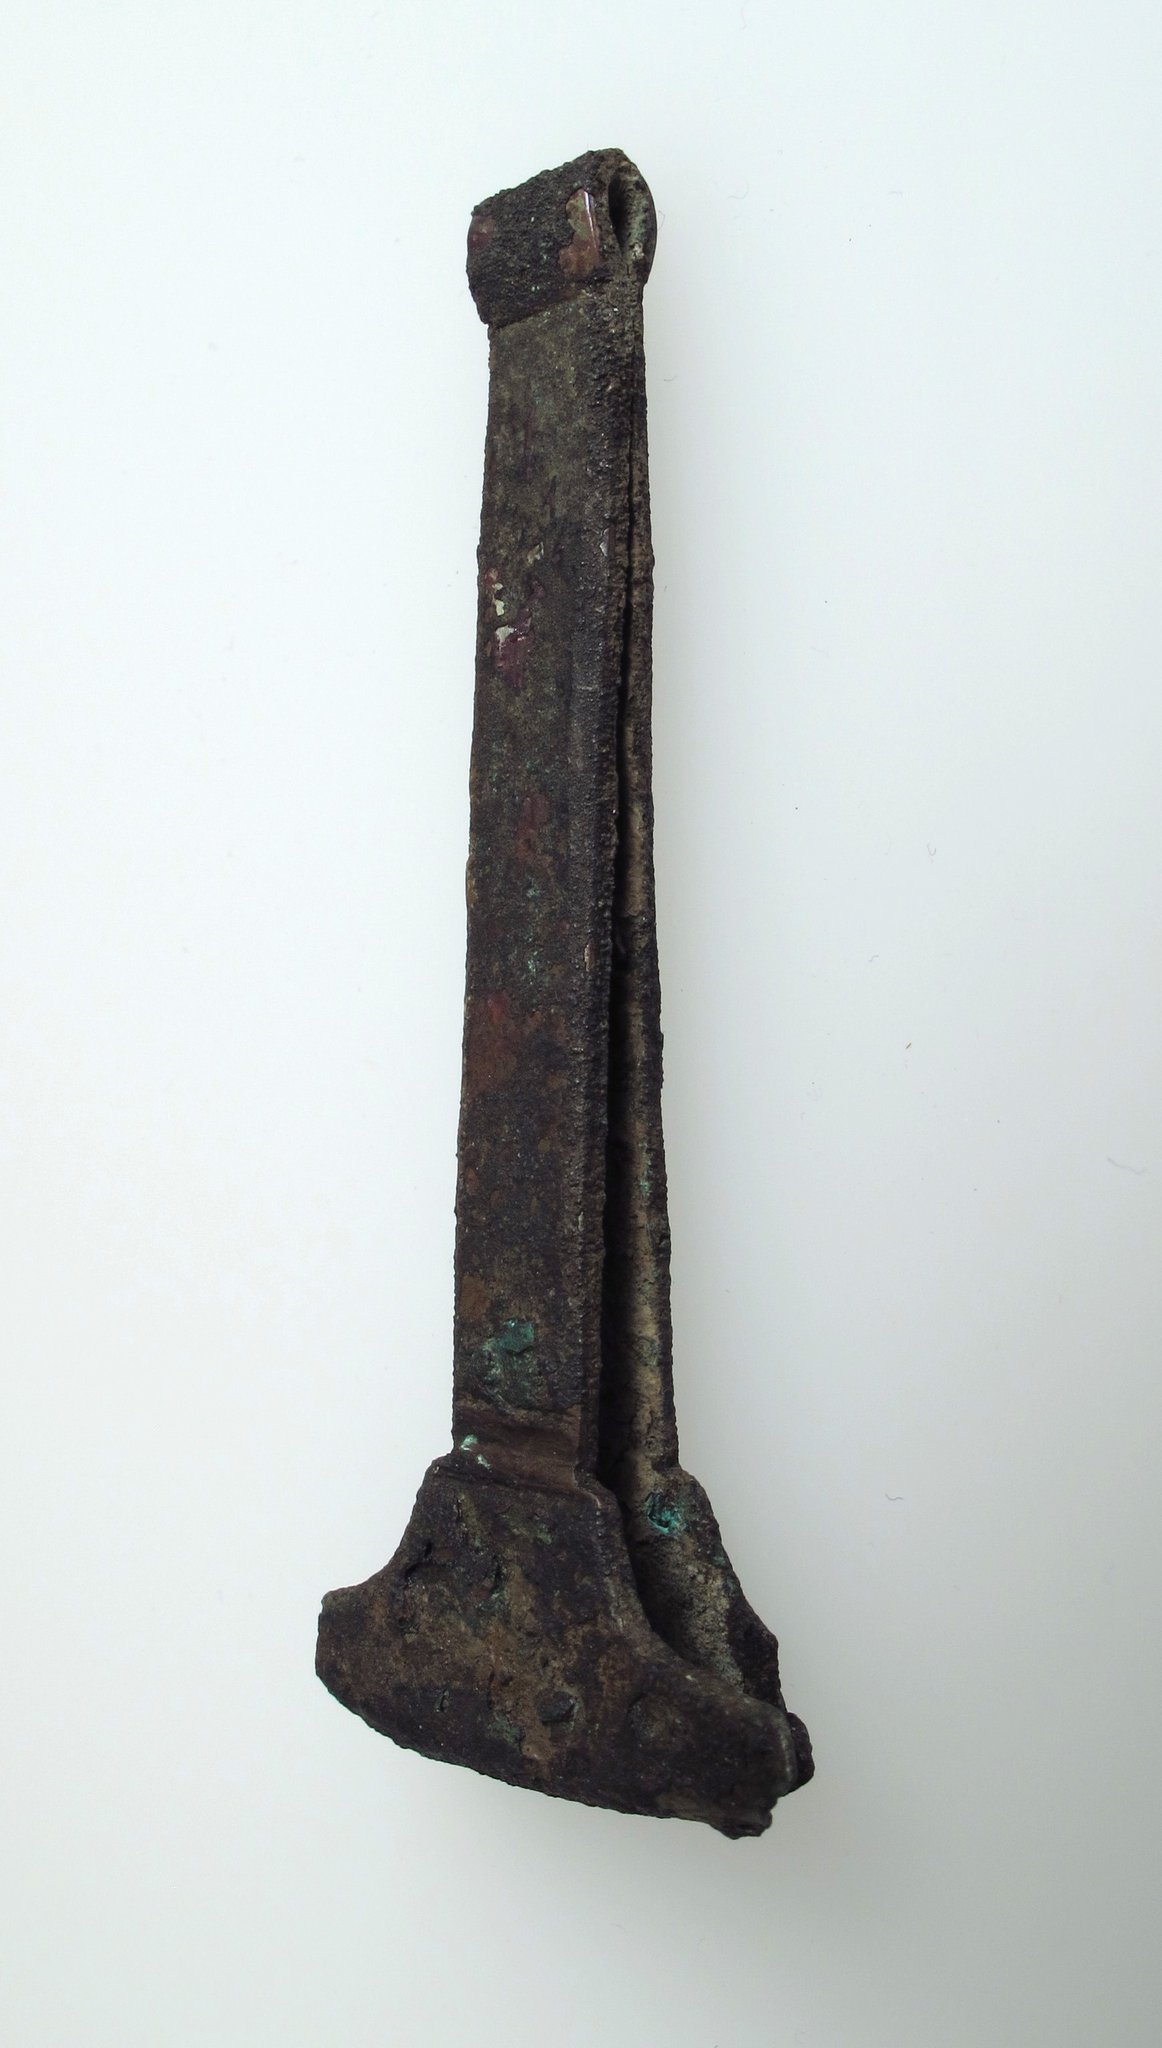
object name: tweezer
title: Tweezers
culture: frankish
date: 601-700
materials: copper alloy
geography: germany